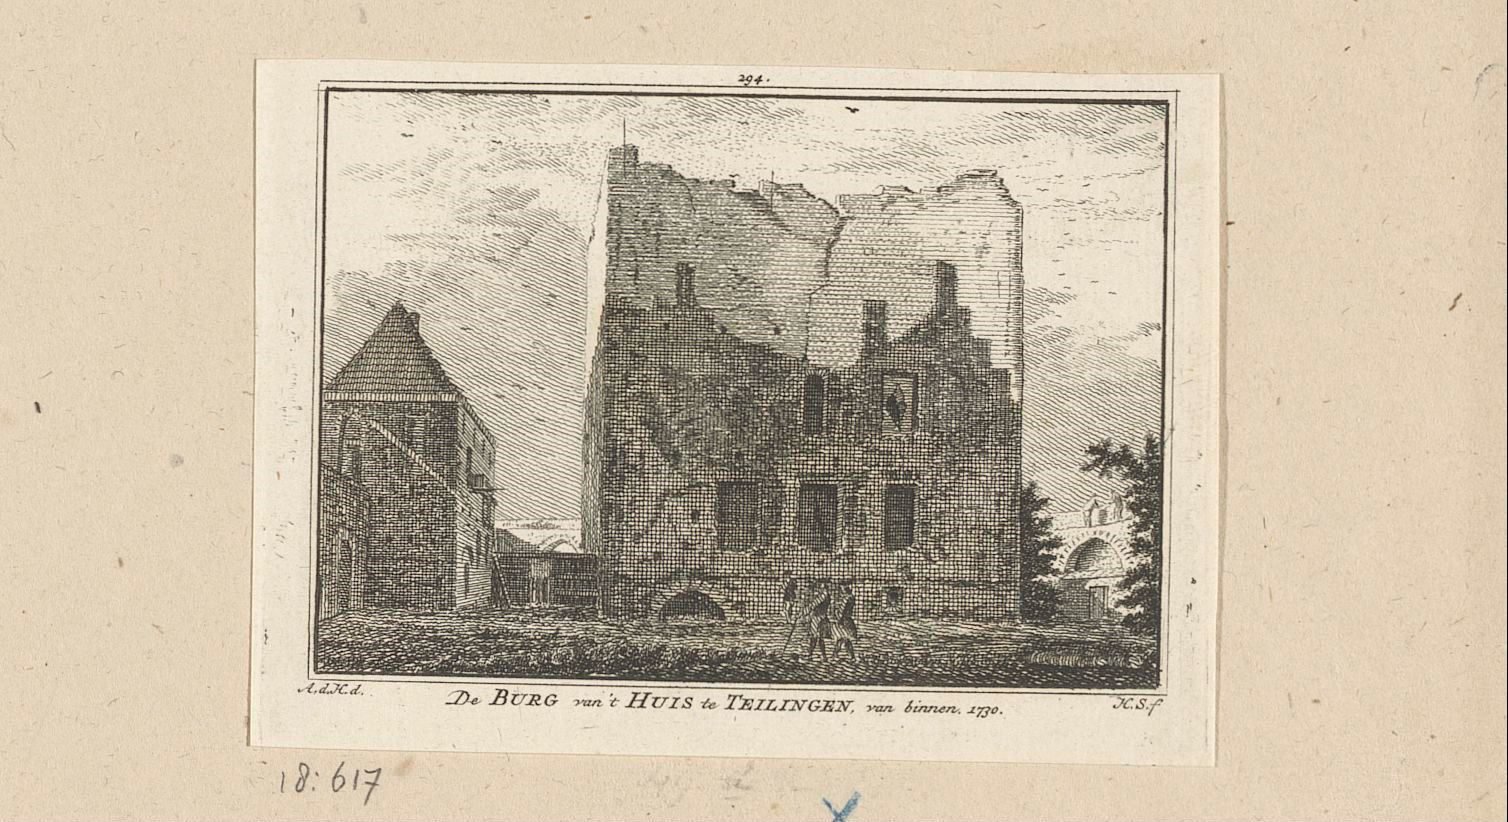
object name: book illustration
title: De burg van 't Huis te Teilingen, van binnen. 1730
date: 1750-1792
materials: paper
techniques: engraving, etching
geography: haarlem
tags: ruin of a dwelling, house, castle, etc.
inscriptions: collector's mark: Lugt 2228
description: Prent ook gebruikt in: Het verheerlykt Nederland of kabinet van hedendaagsche gezigten van steden, dorpen (…). 9 delen. Amsterdam: Isaak Tirion en weduwe Isaak Tirion, 1745-1774, dl. 3 (1750), ill. 294. Of in: Nederlandsche tafereelen; of eene keurige verzameling van negen honderd fraaije gezigten van steden, dorpen, sloten, oudheden (….). 9 delen. Amsterdam: Jan de Groot, 1792, dl. 3, ill. 294.